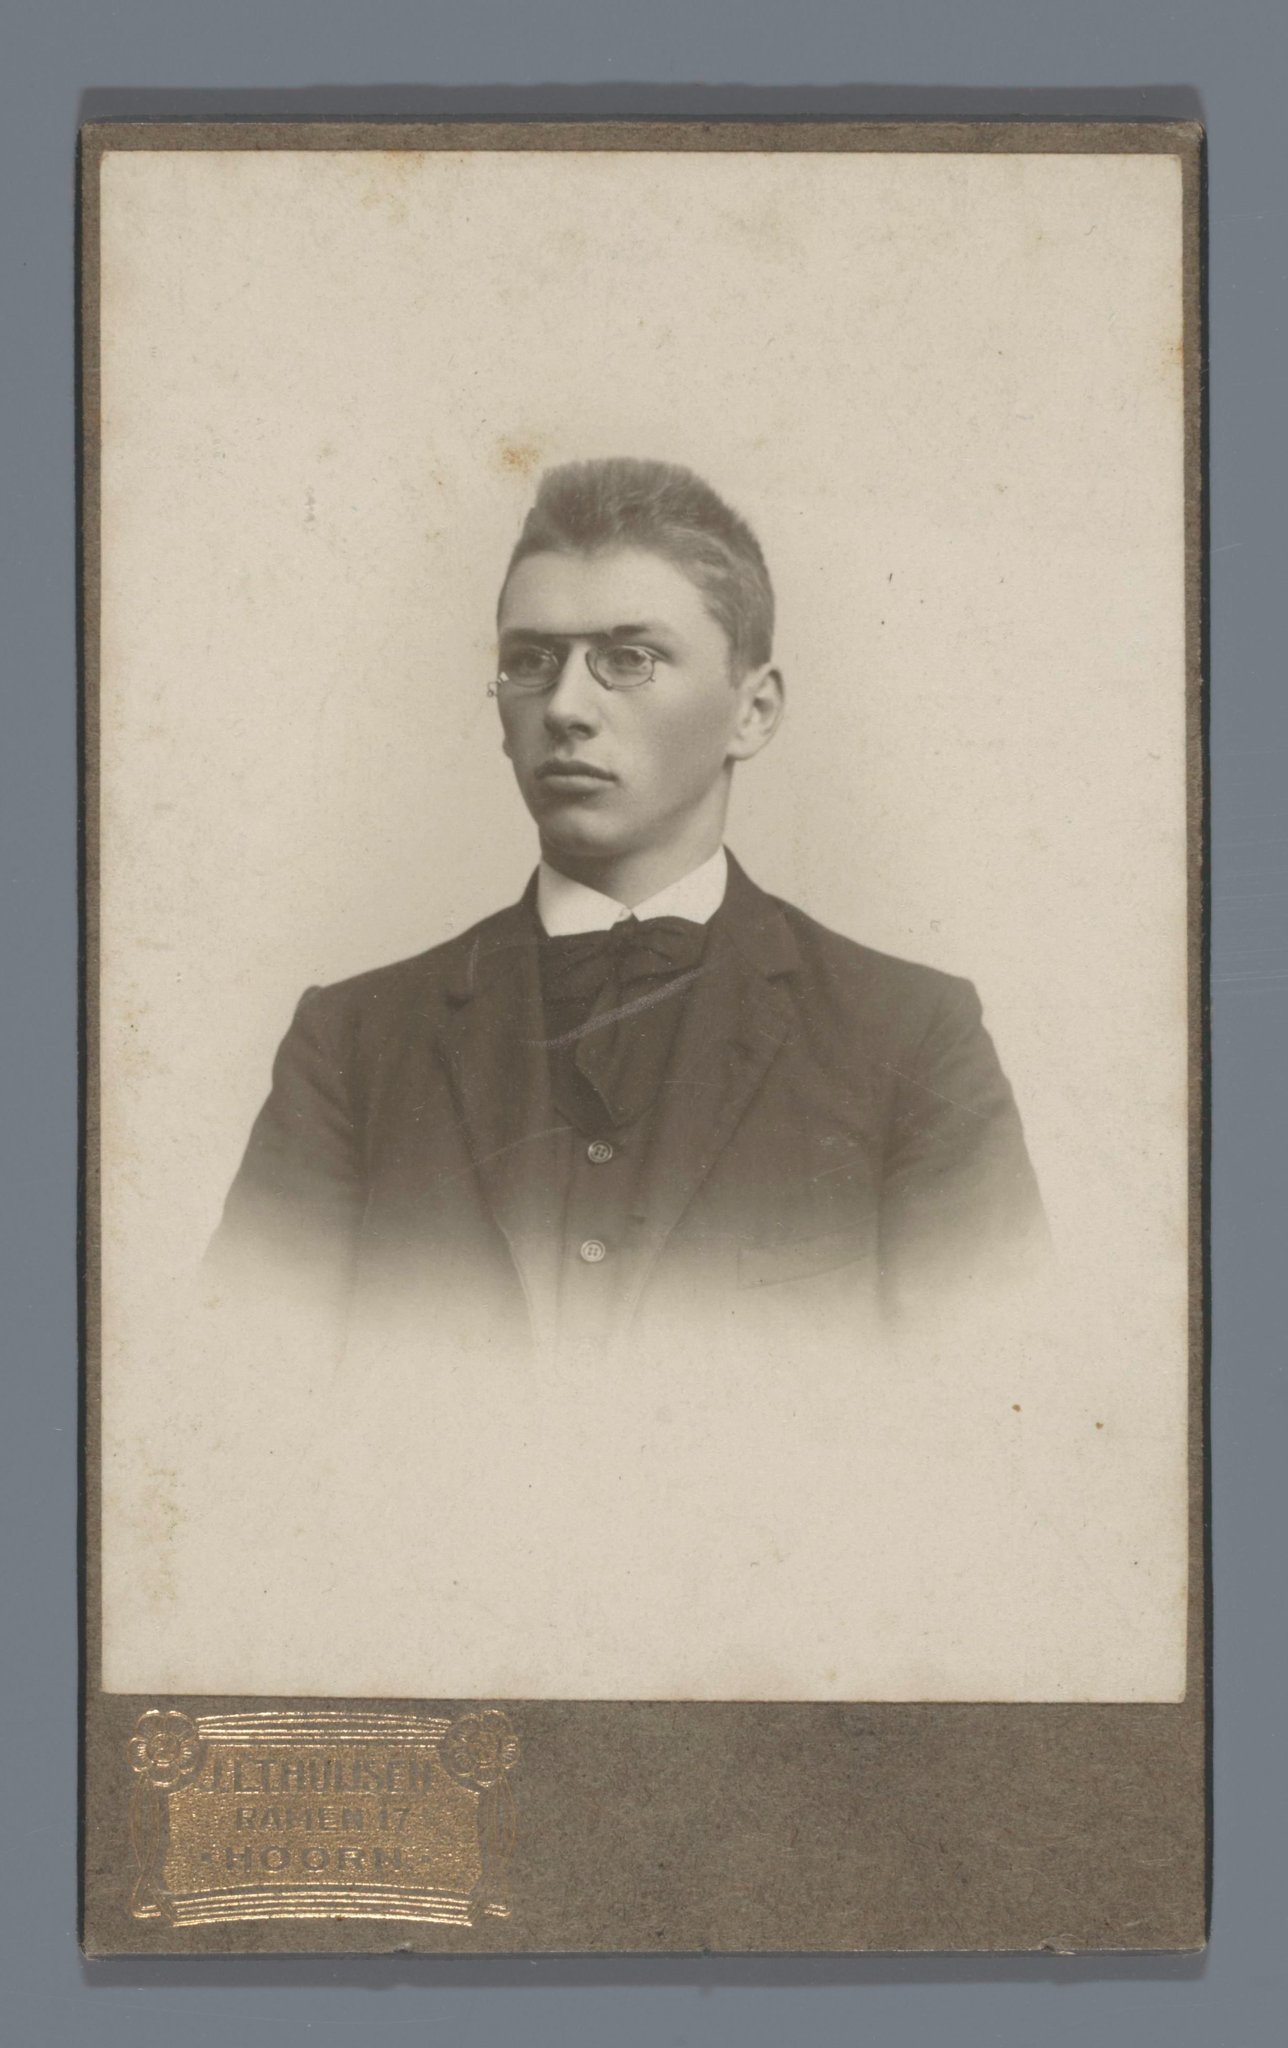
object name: carte de visite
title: Prof. Dr. W. Banning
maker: johannes laurens theodorus huijsen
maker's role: fotograaf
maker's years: 1852-1910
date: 1880-1920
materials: paper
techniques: matte daylight collodion silver print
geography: hoorn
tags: politician, historical persons, netherlands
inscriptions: signature: ‘J. L. T. Huijsen, Ramen 17 Hoorn’, inscription: ‘Prof. Dr. W. Banning’